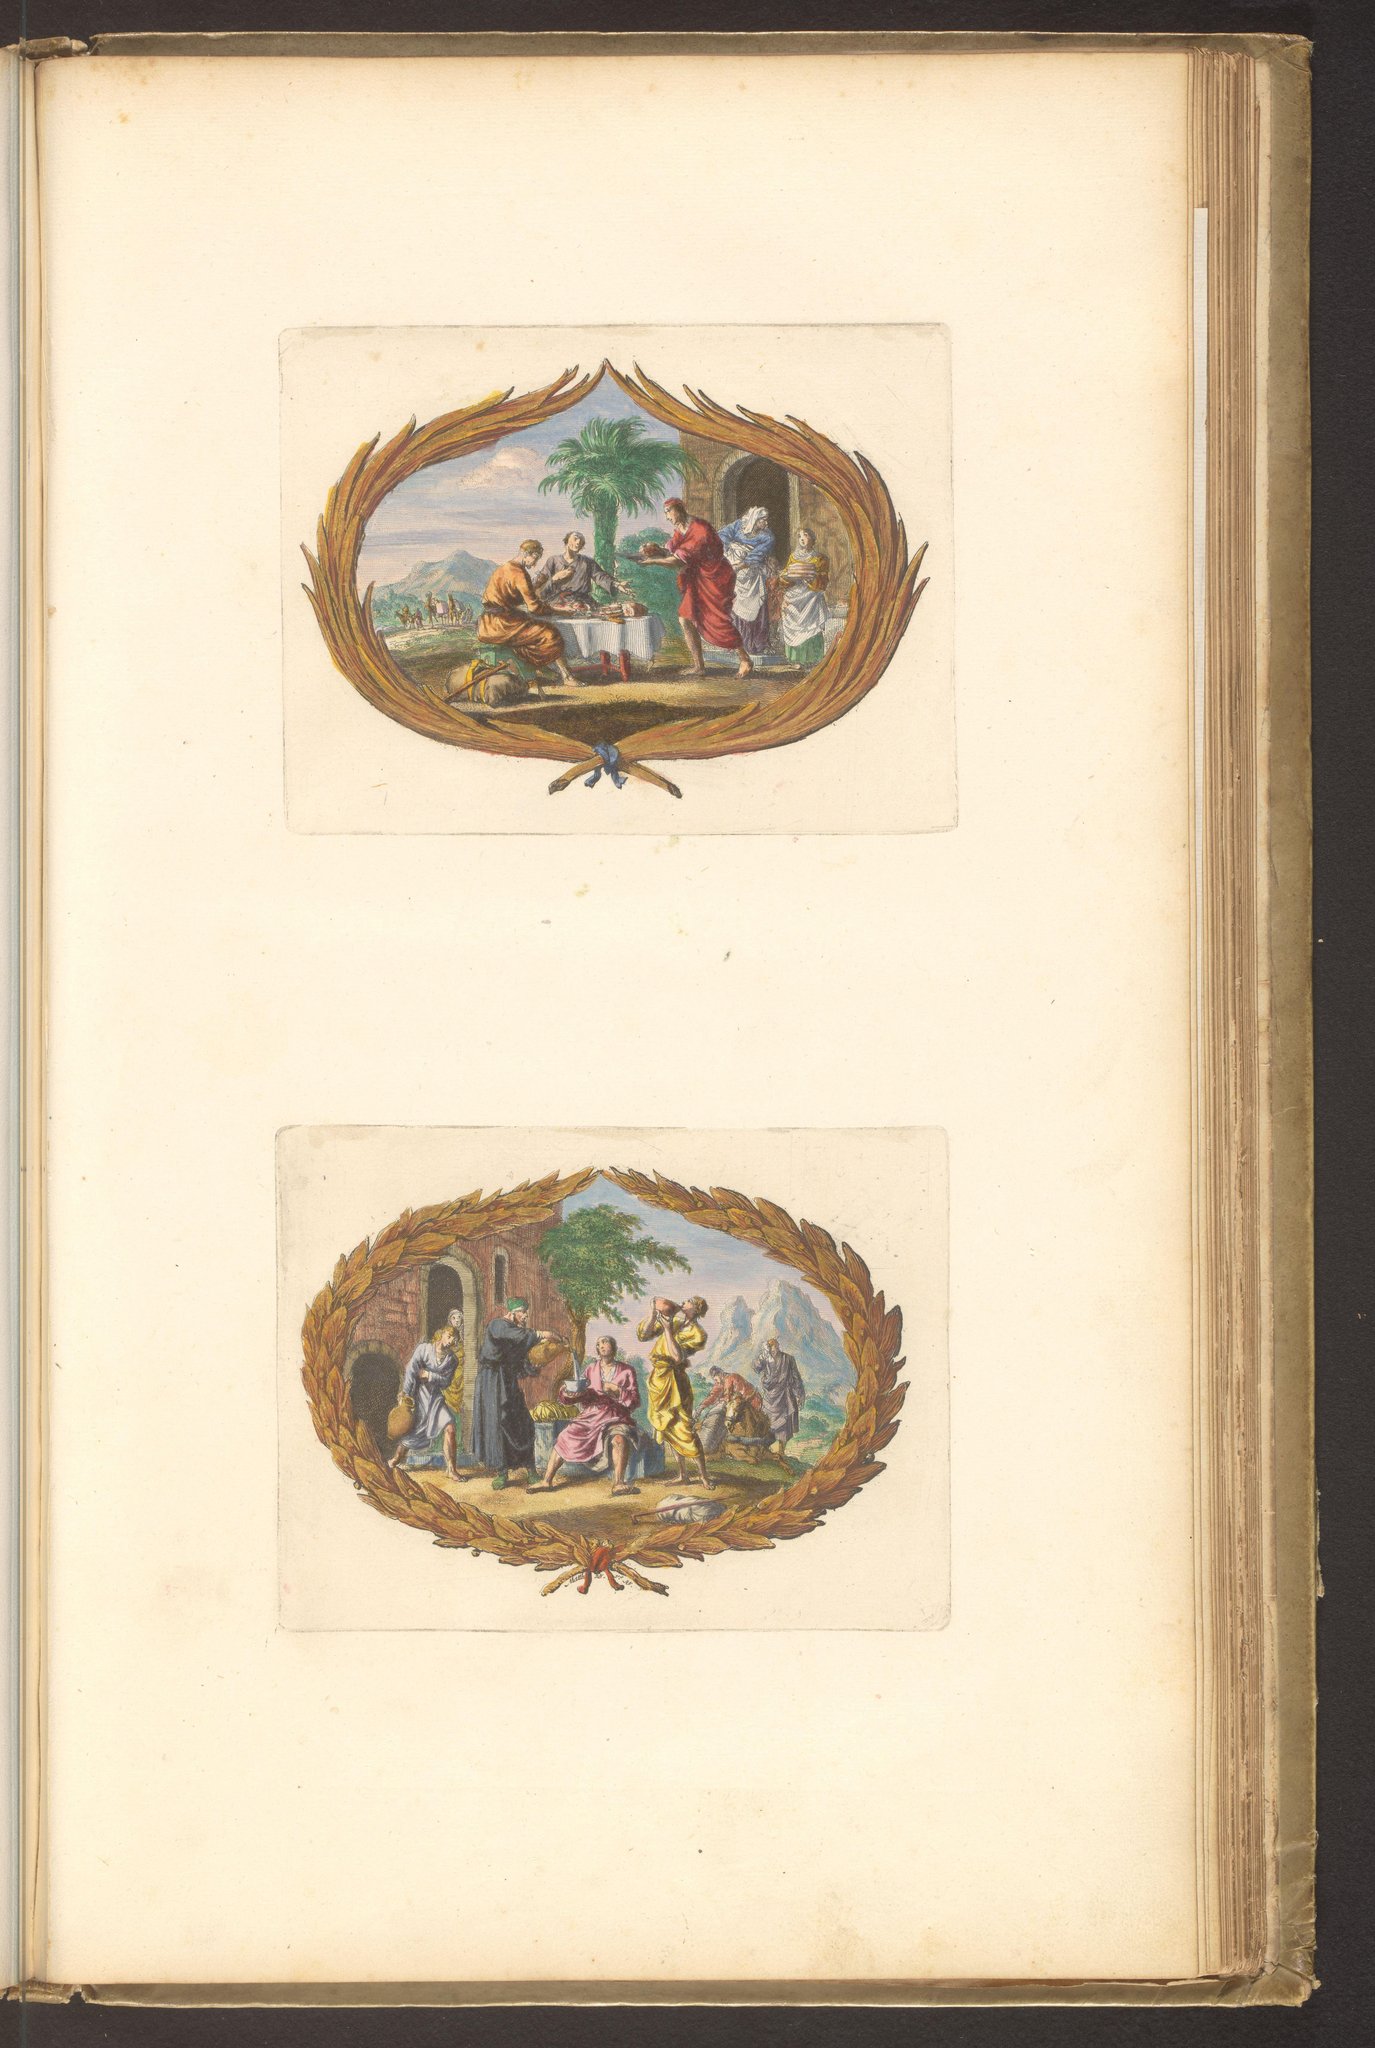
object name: print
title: Blad met twee vignetten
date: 1700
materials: paint, paper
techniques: etching, hand coloring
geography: amsterdam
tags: giving the thirsty to drink, 'sitiens potatur' ~ one of the (seven) acts of mercy, feeding the hungry, 'esuriens cibatur' ~ one of the (seven) acts of mercy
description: Blad met twee vignetten. Boven: de Hongerigen spijzen. Onder: de Dorstigen laven. Blad in het tweede deel van de prentbijbel met het Nieuwe Testament, uitgegeven door Pieter Mortier, Amsterdam 1700.